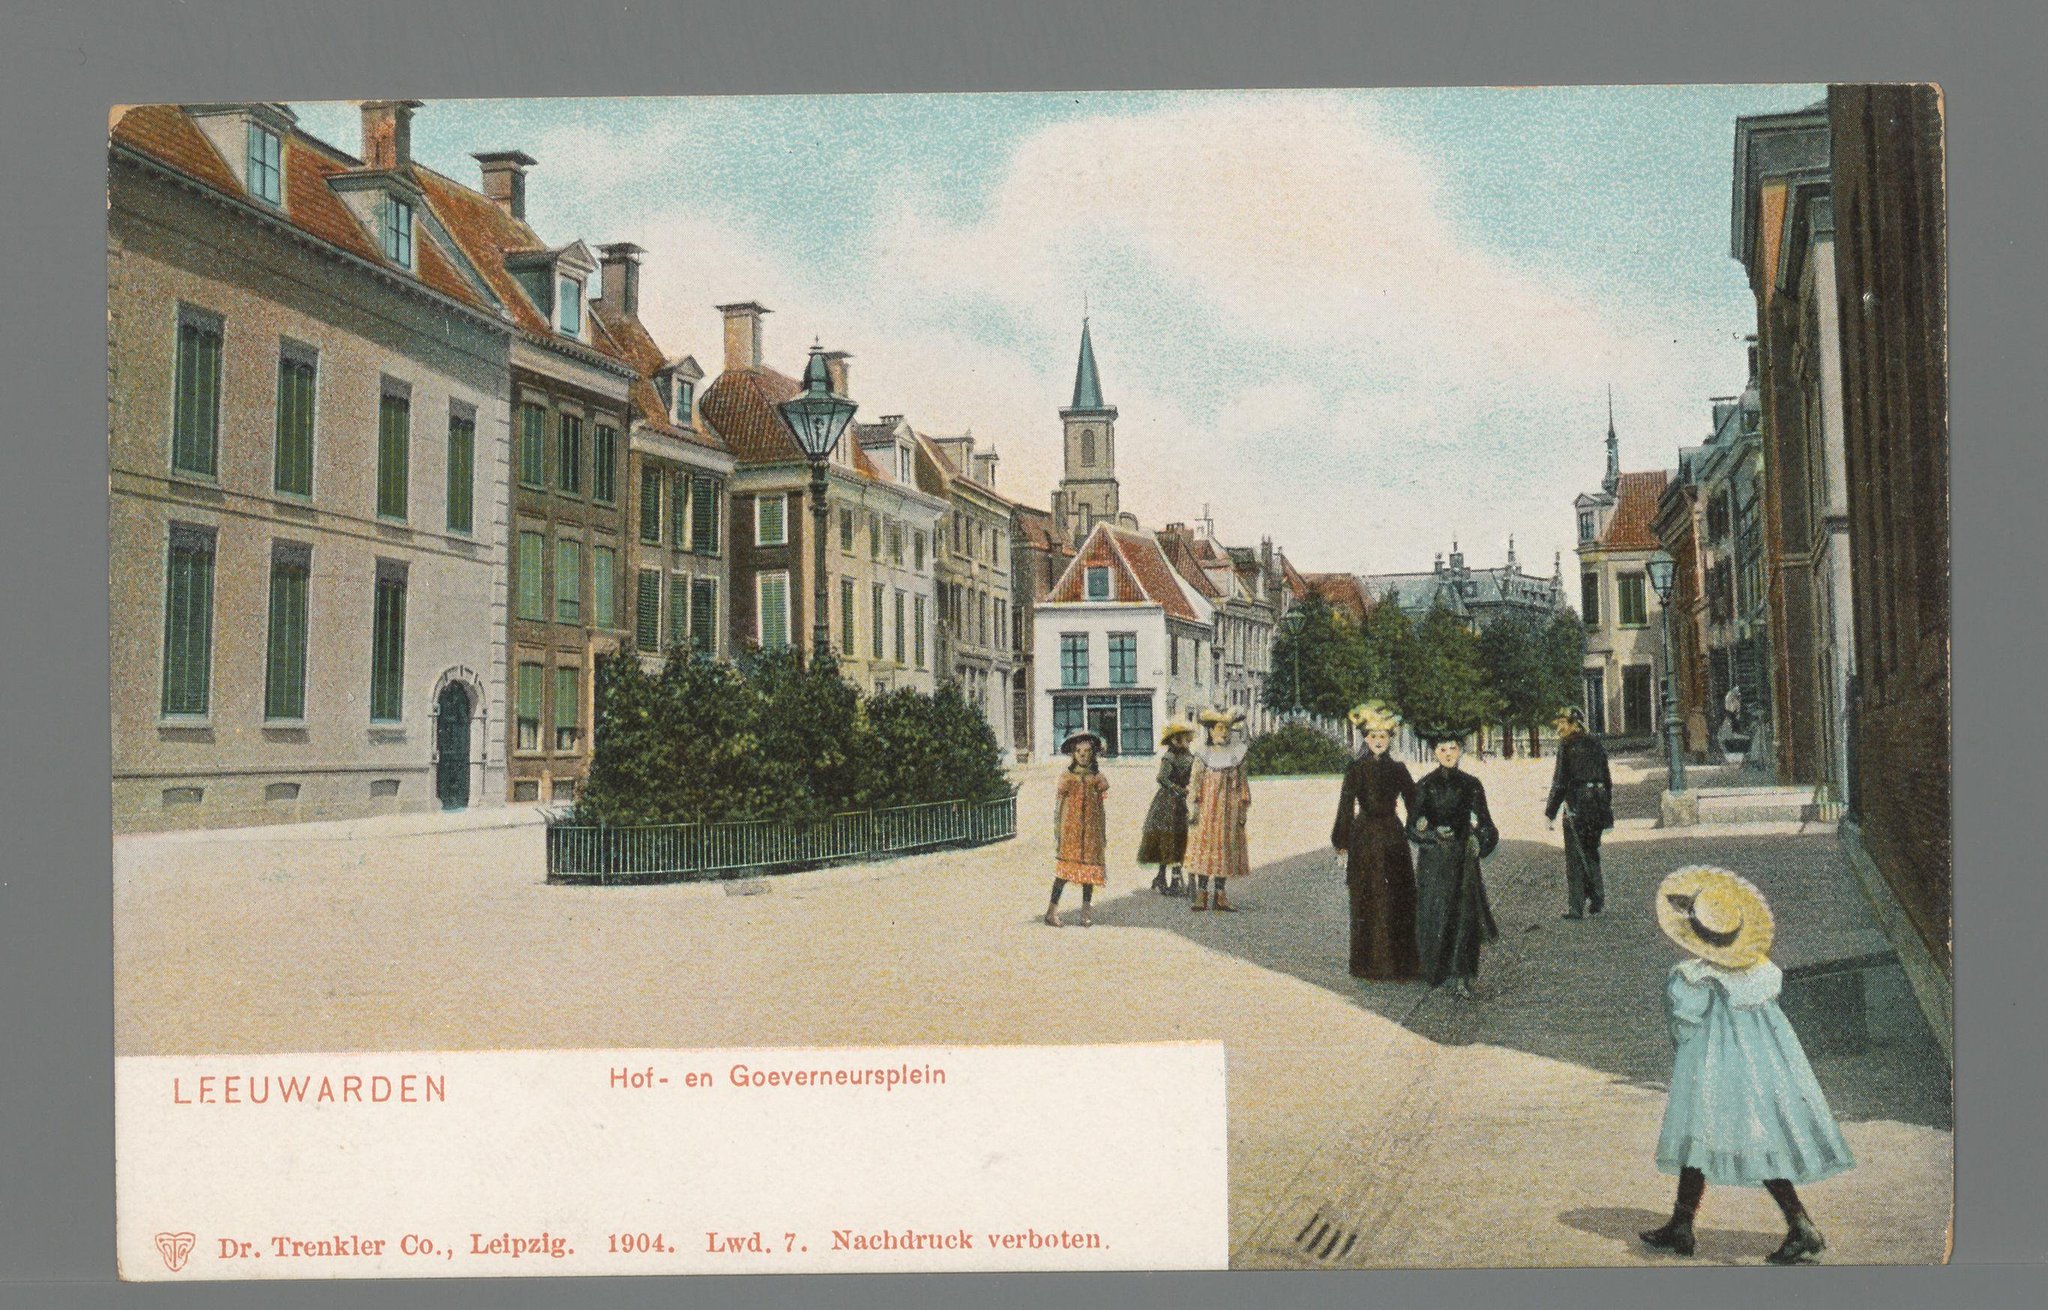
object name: ansichtkaart, prentbriefkaart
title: Leeuwarden. Hof- en Goeverneursplein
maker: Anonymous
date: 1904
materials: cardboard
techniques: lithograph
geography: leipzig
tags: square, place, circus, etc., parts of church exterior and annexes: tower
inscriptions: date